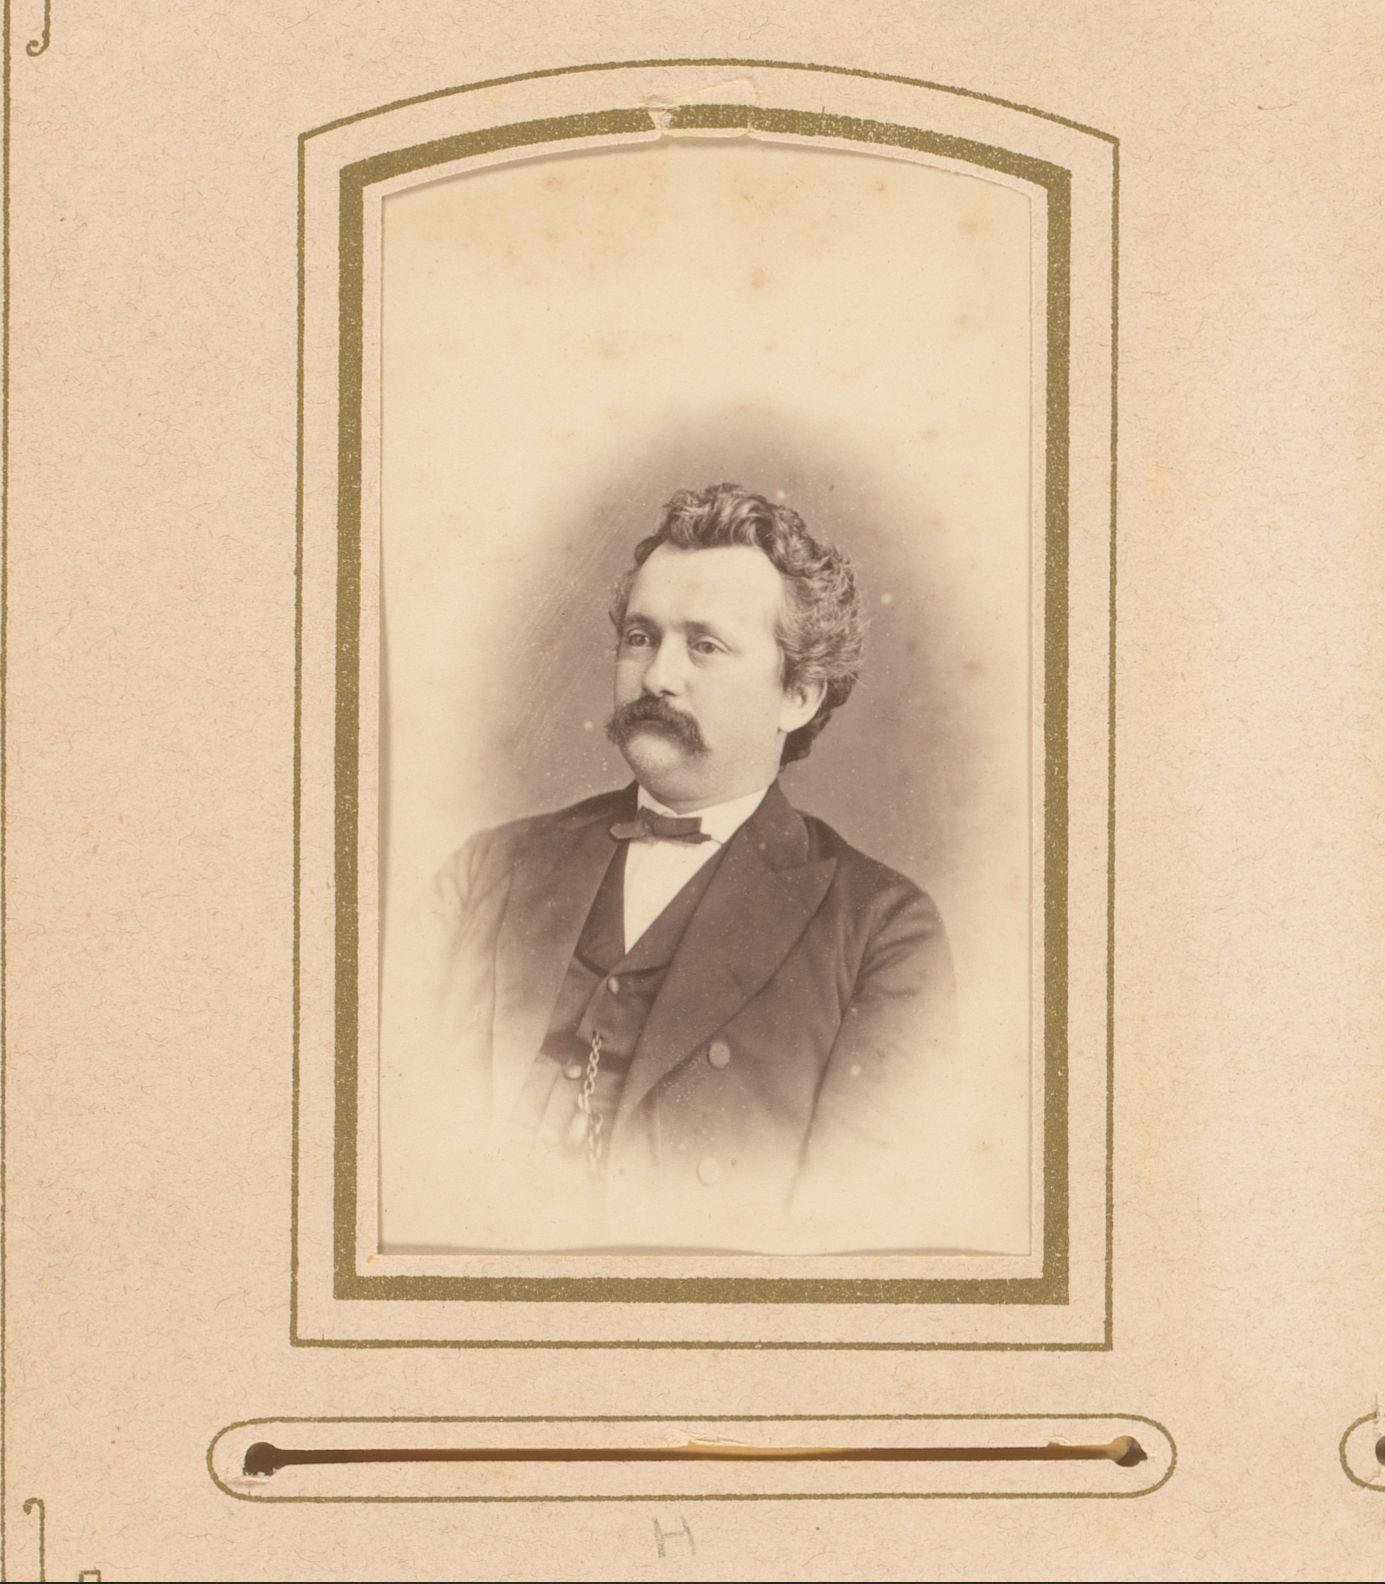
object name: photograph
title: Portret van een man met snor en vlinderstrik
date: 1874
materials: cardboard, photographic support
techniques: albumen print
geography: batavia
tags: moustache, historical persons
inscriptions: inscription: ‘Petz & Co.,/ PHOTOGRAFEN,/ BATAVIA.’, dedication: ‘Aan m[ij]ne geliefde/ Zuster Thérèse/ Batavia 21/11.74./ [F]rans.’